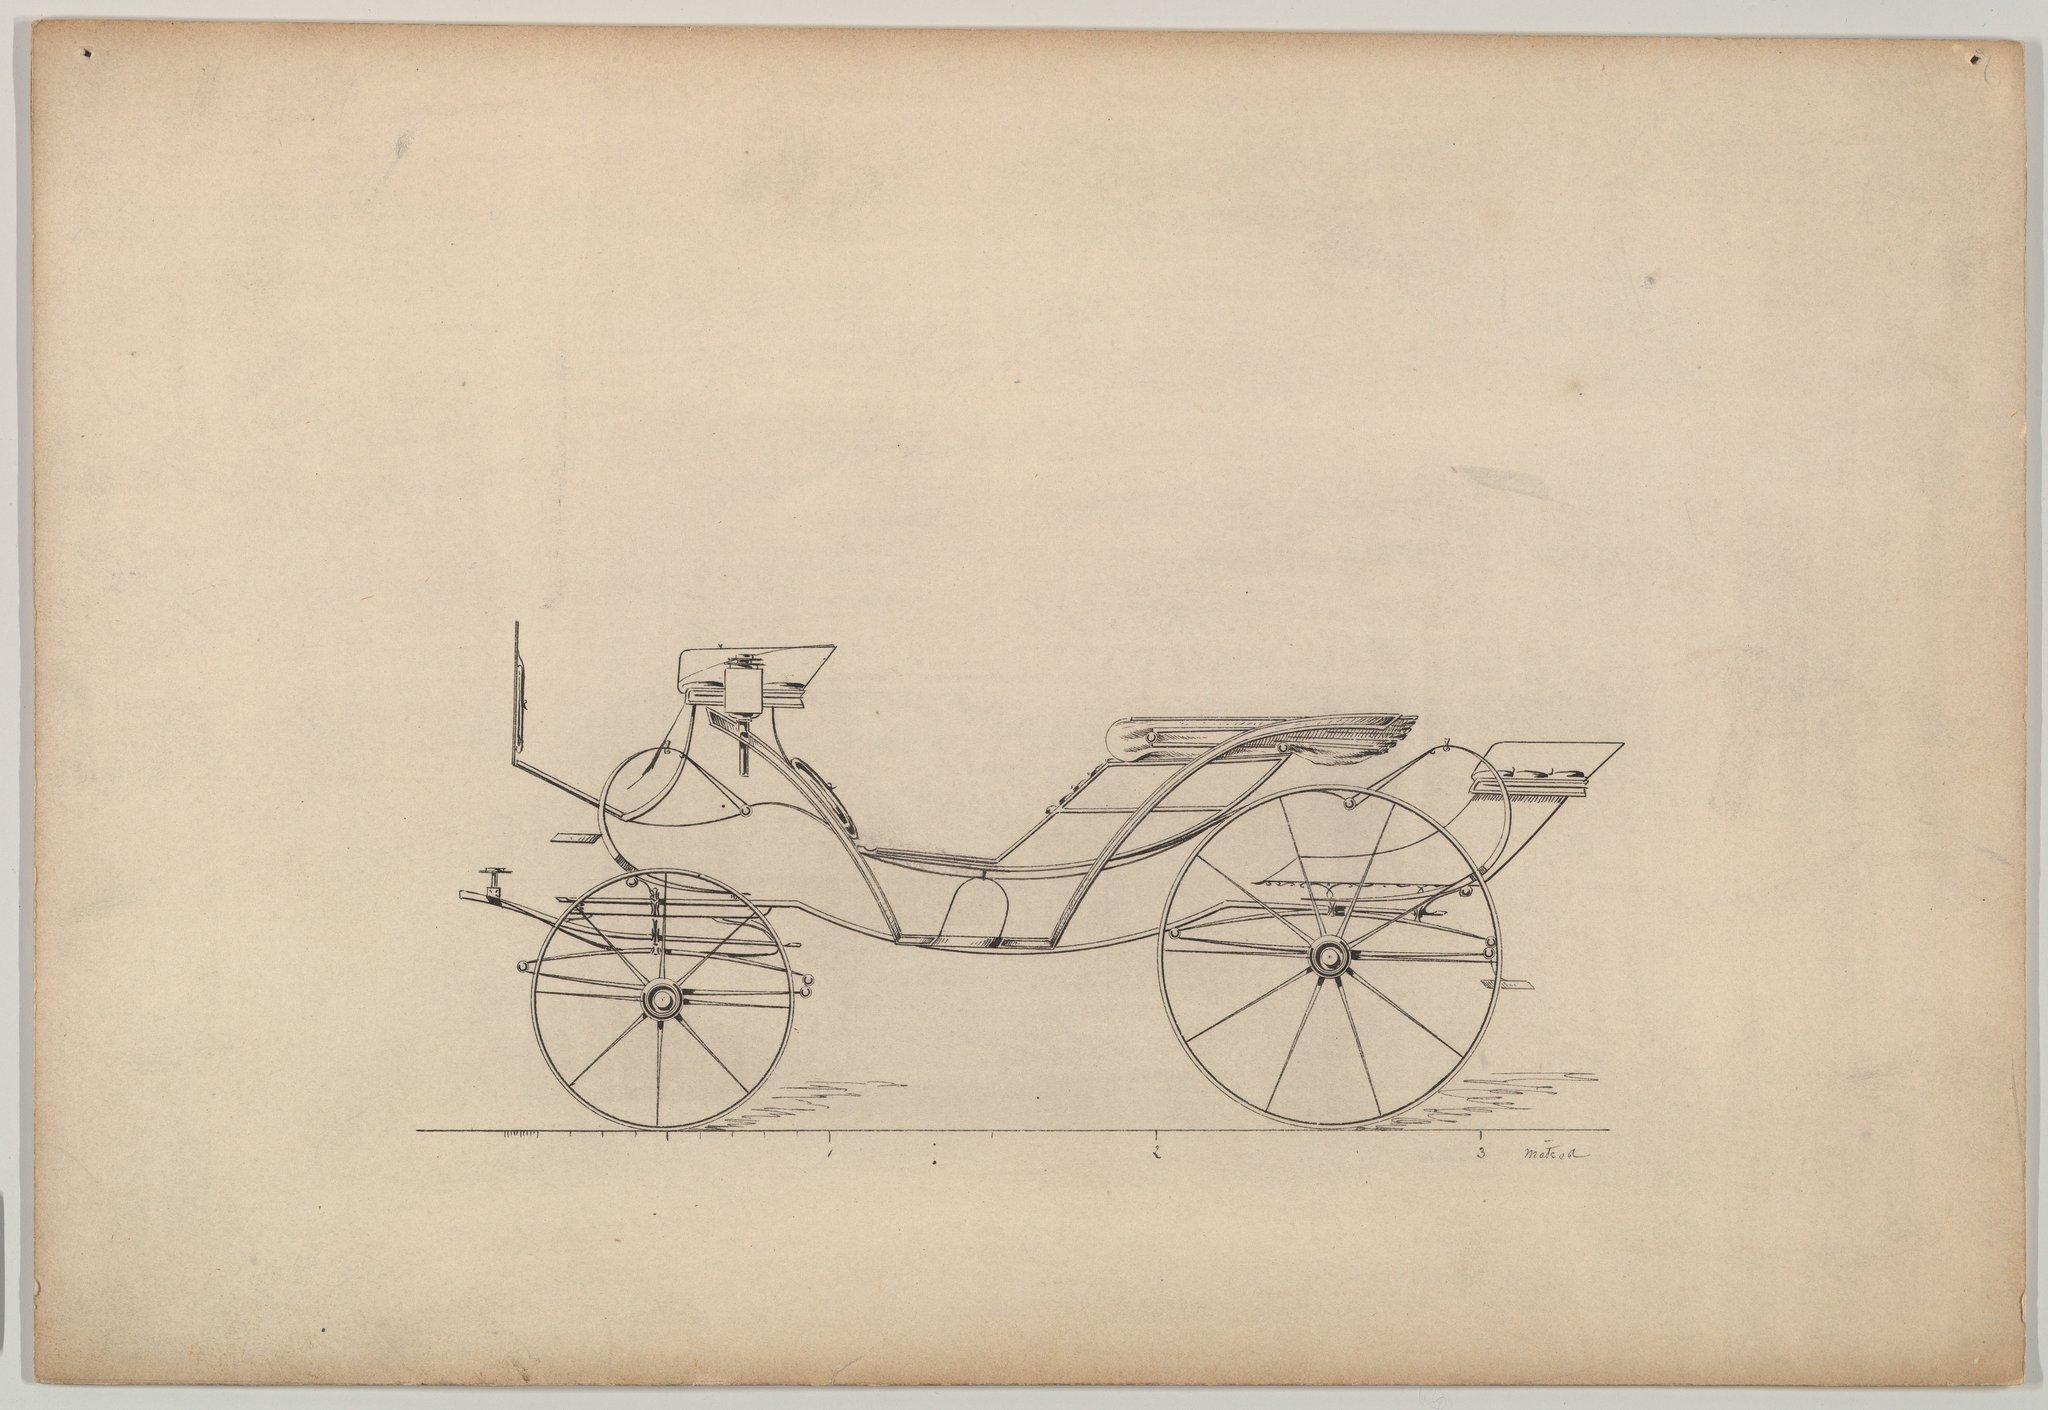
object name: drawing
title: Eight Spring Victoria (unnumbered)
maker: brewster & co.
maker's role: manufacturer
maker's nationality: american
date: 1870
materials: ink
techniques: pen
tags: carriages